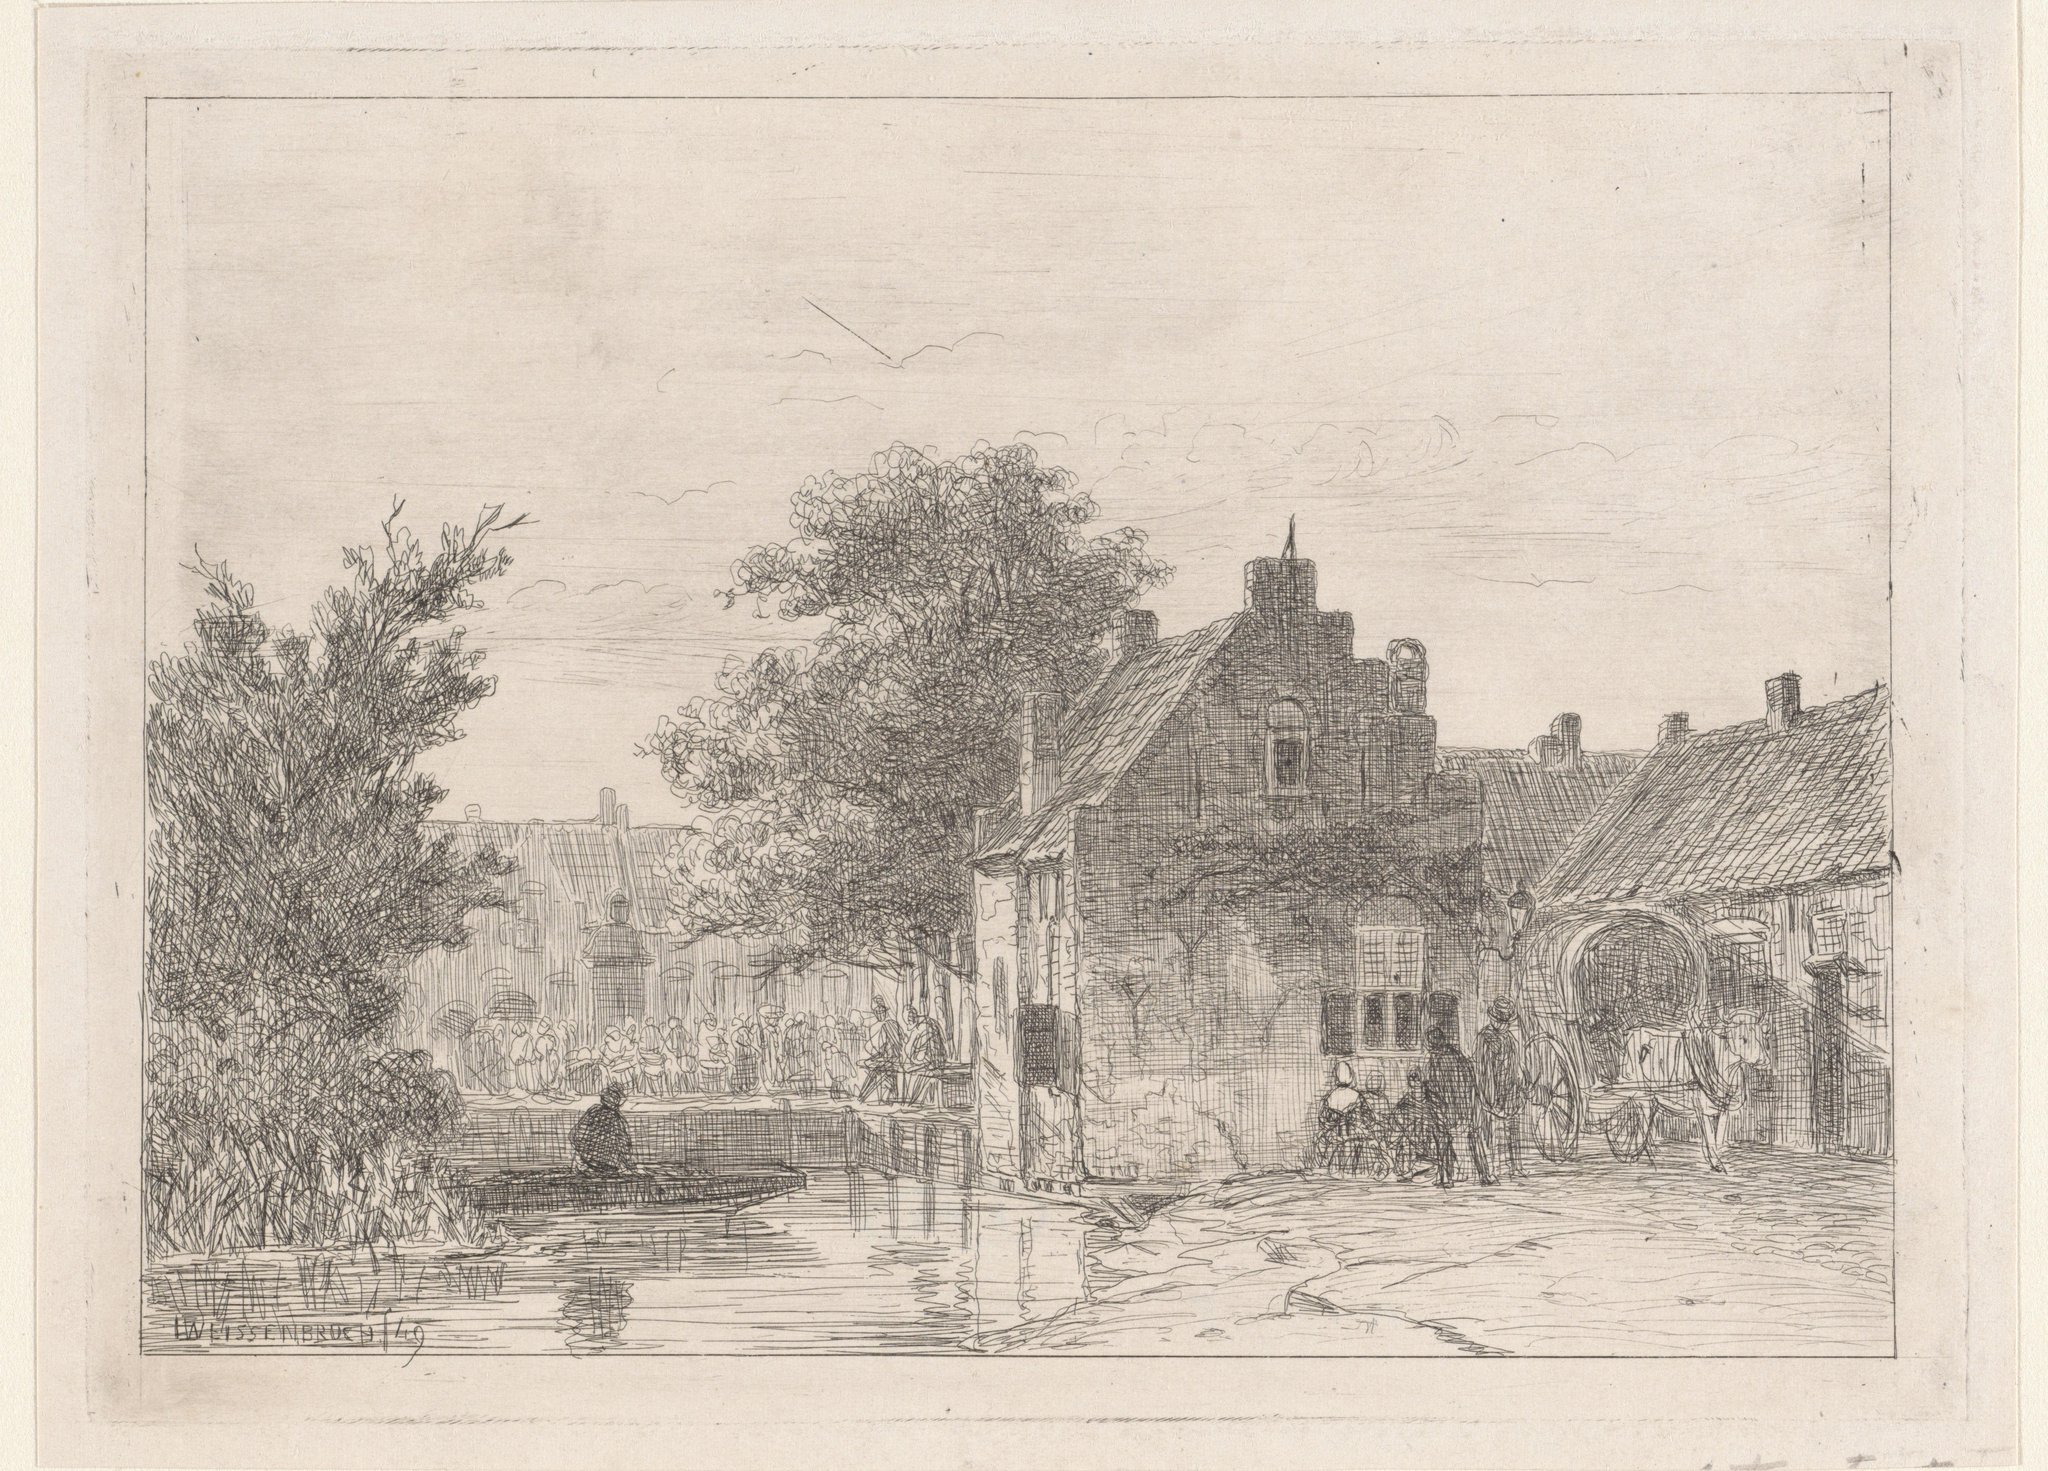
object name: print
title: Markt te Boxtel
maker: jan weissenbruch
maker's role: painter, print maker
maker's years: 1822-1880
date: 1849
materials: paper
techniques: etching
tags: urban housing, city-view, and landscape with man-made constructions, trees, adult woman, adult man, canal, rowing-boat, canoe, etc., horse, market, (farm) wagon, freight wagon, cart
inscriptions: collector's mark: Lugt 2228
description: In de verte is een druk marktplein te zien. Links vaart een man in een boot over een klein kanaal. Rechts zitten enkele figuren voor een huis met een trapgevel. Op de weg ernaast staat een paard-en-wagen.